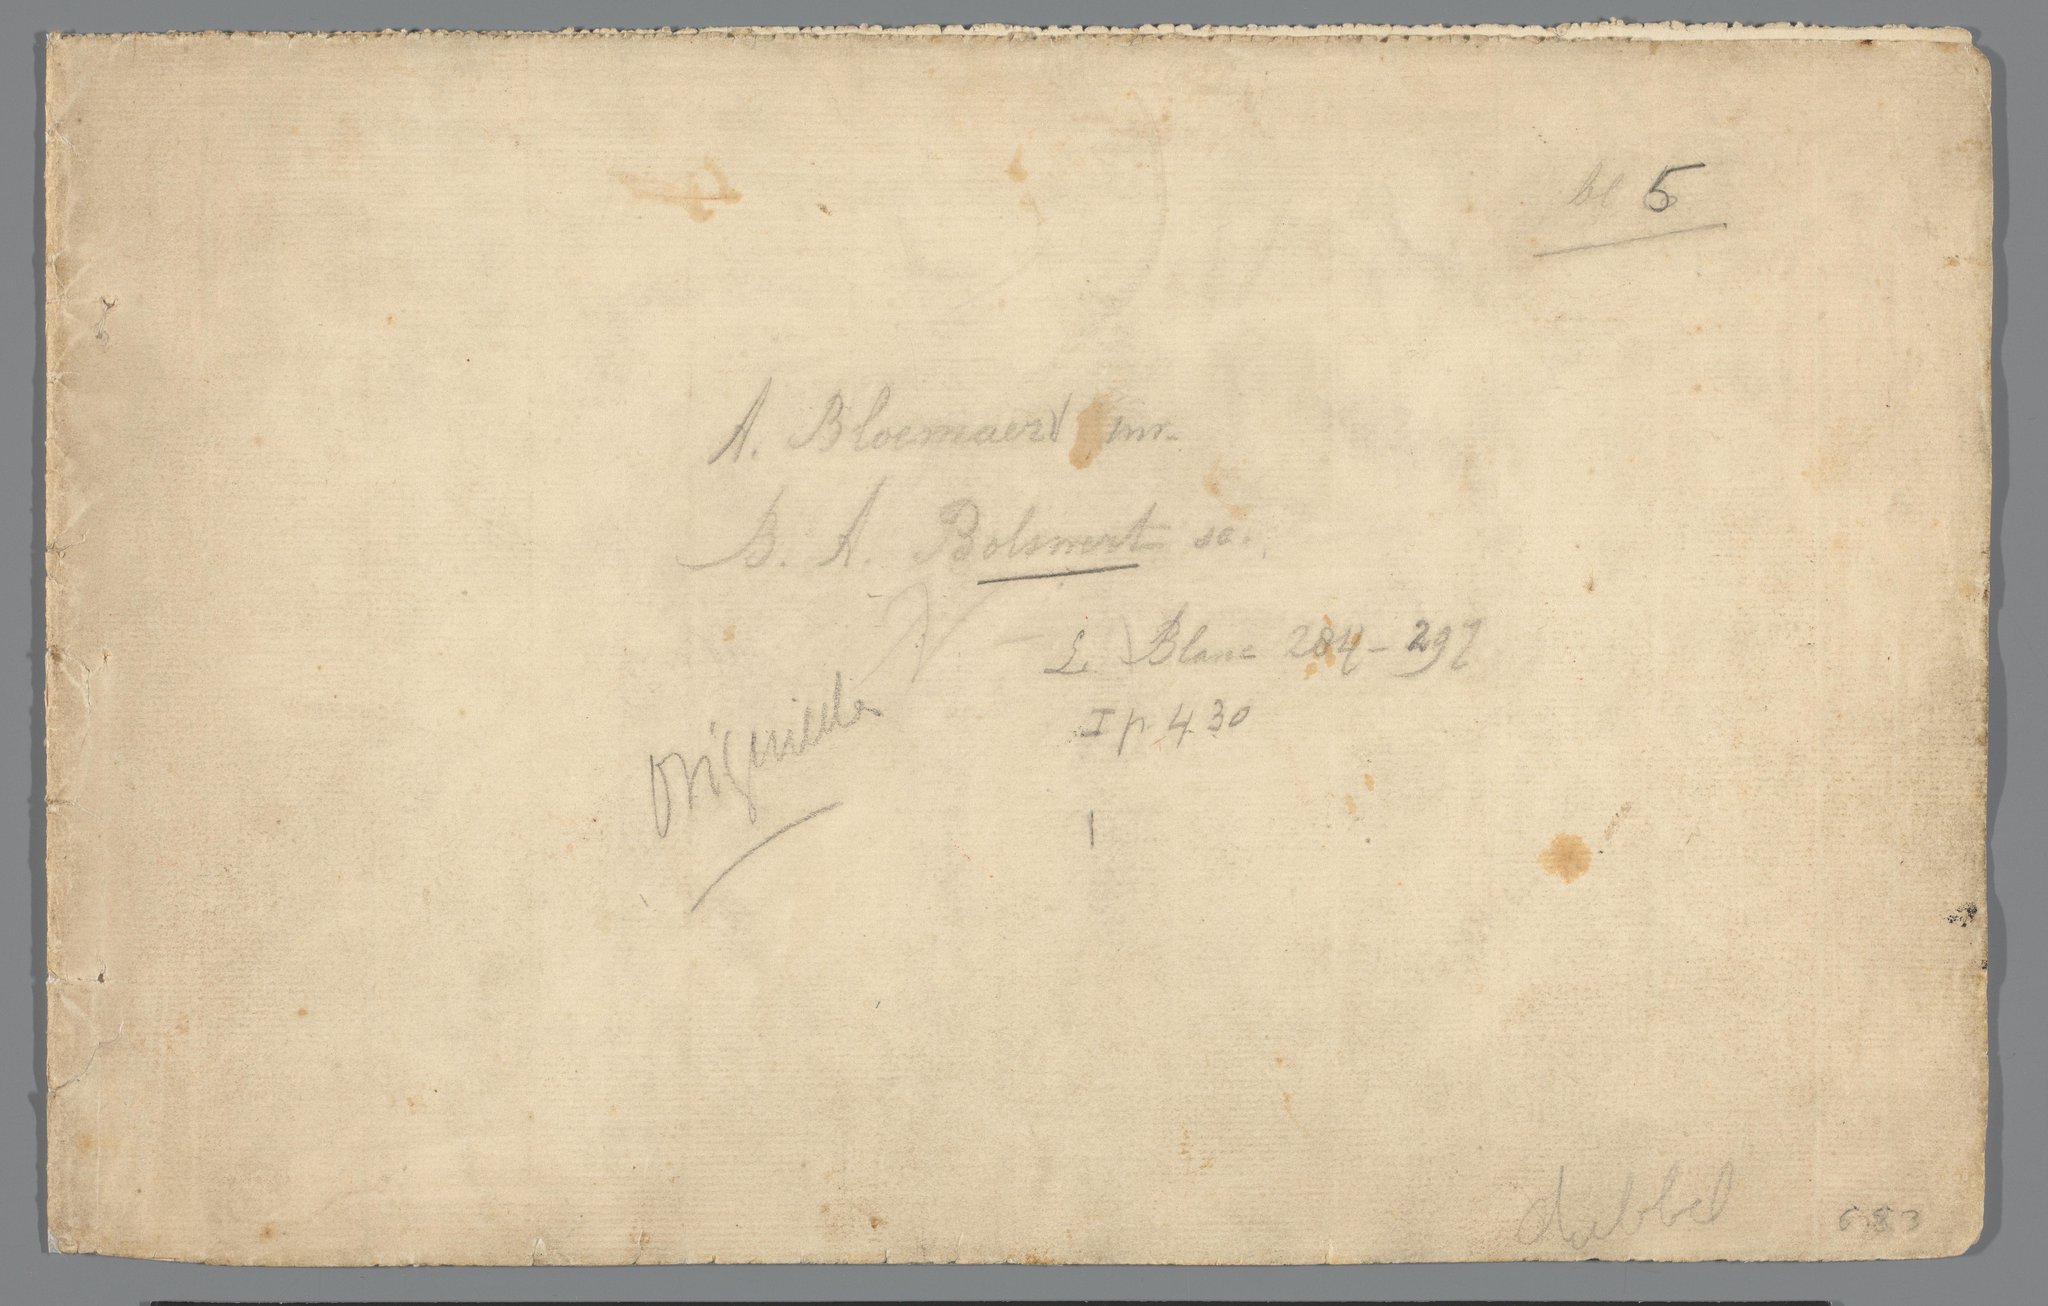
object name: wrapper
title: Omslag voor veertien prenten met dieren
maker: Anonymous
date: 1717-1732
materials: paper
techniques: scooping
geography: netherlands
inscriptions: inscription: ‘Origineelen’, inscription: ‘A. Bloemaert inv./ B.A. Bolswert sc.’